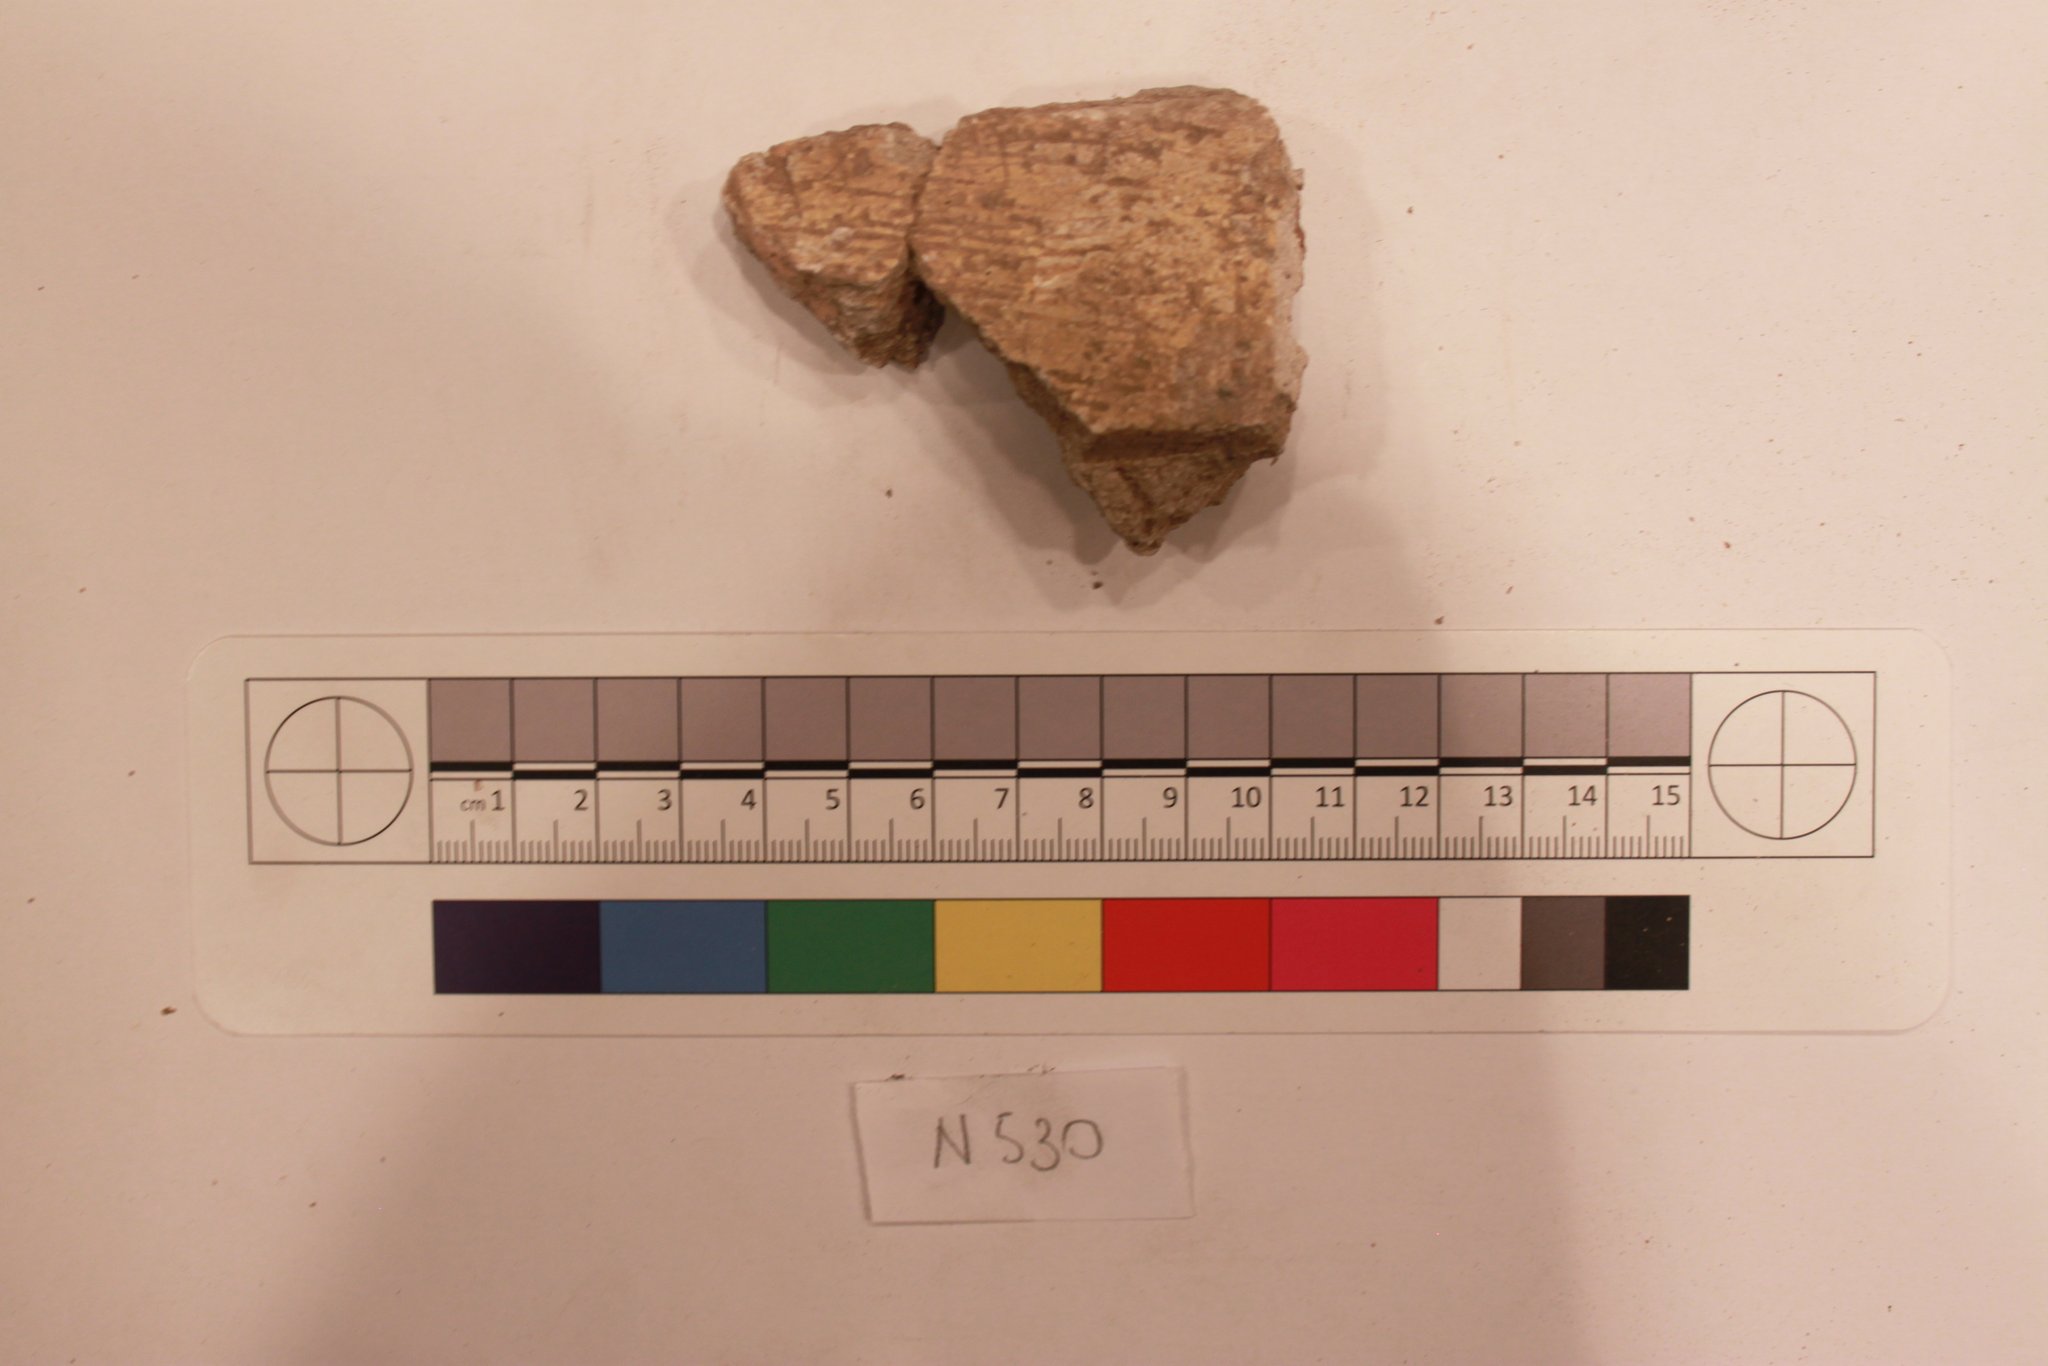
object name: fragment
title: Stucco Fragment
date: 701-1200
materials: plaster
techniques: carving, painting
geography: iran